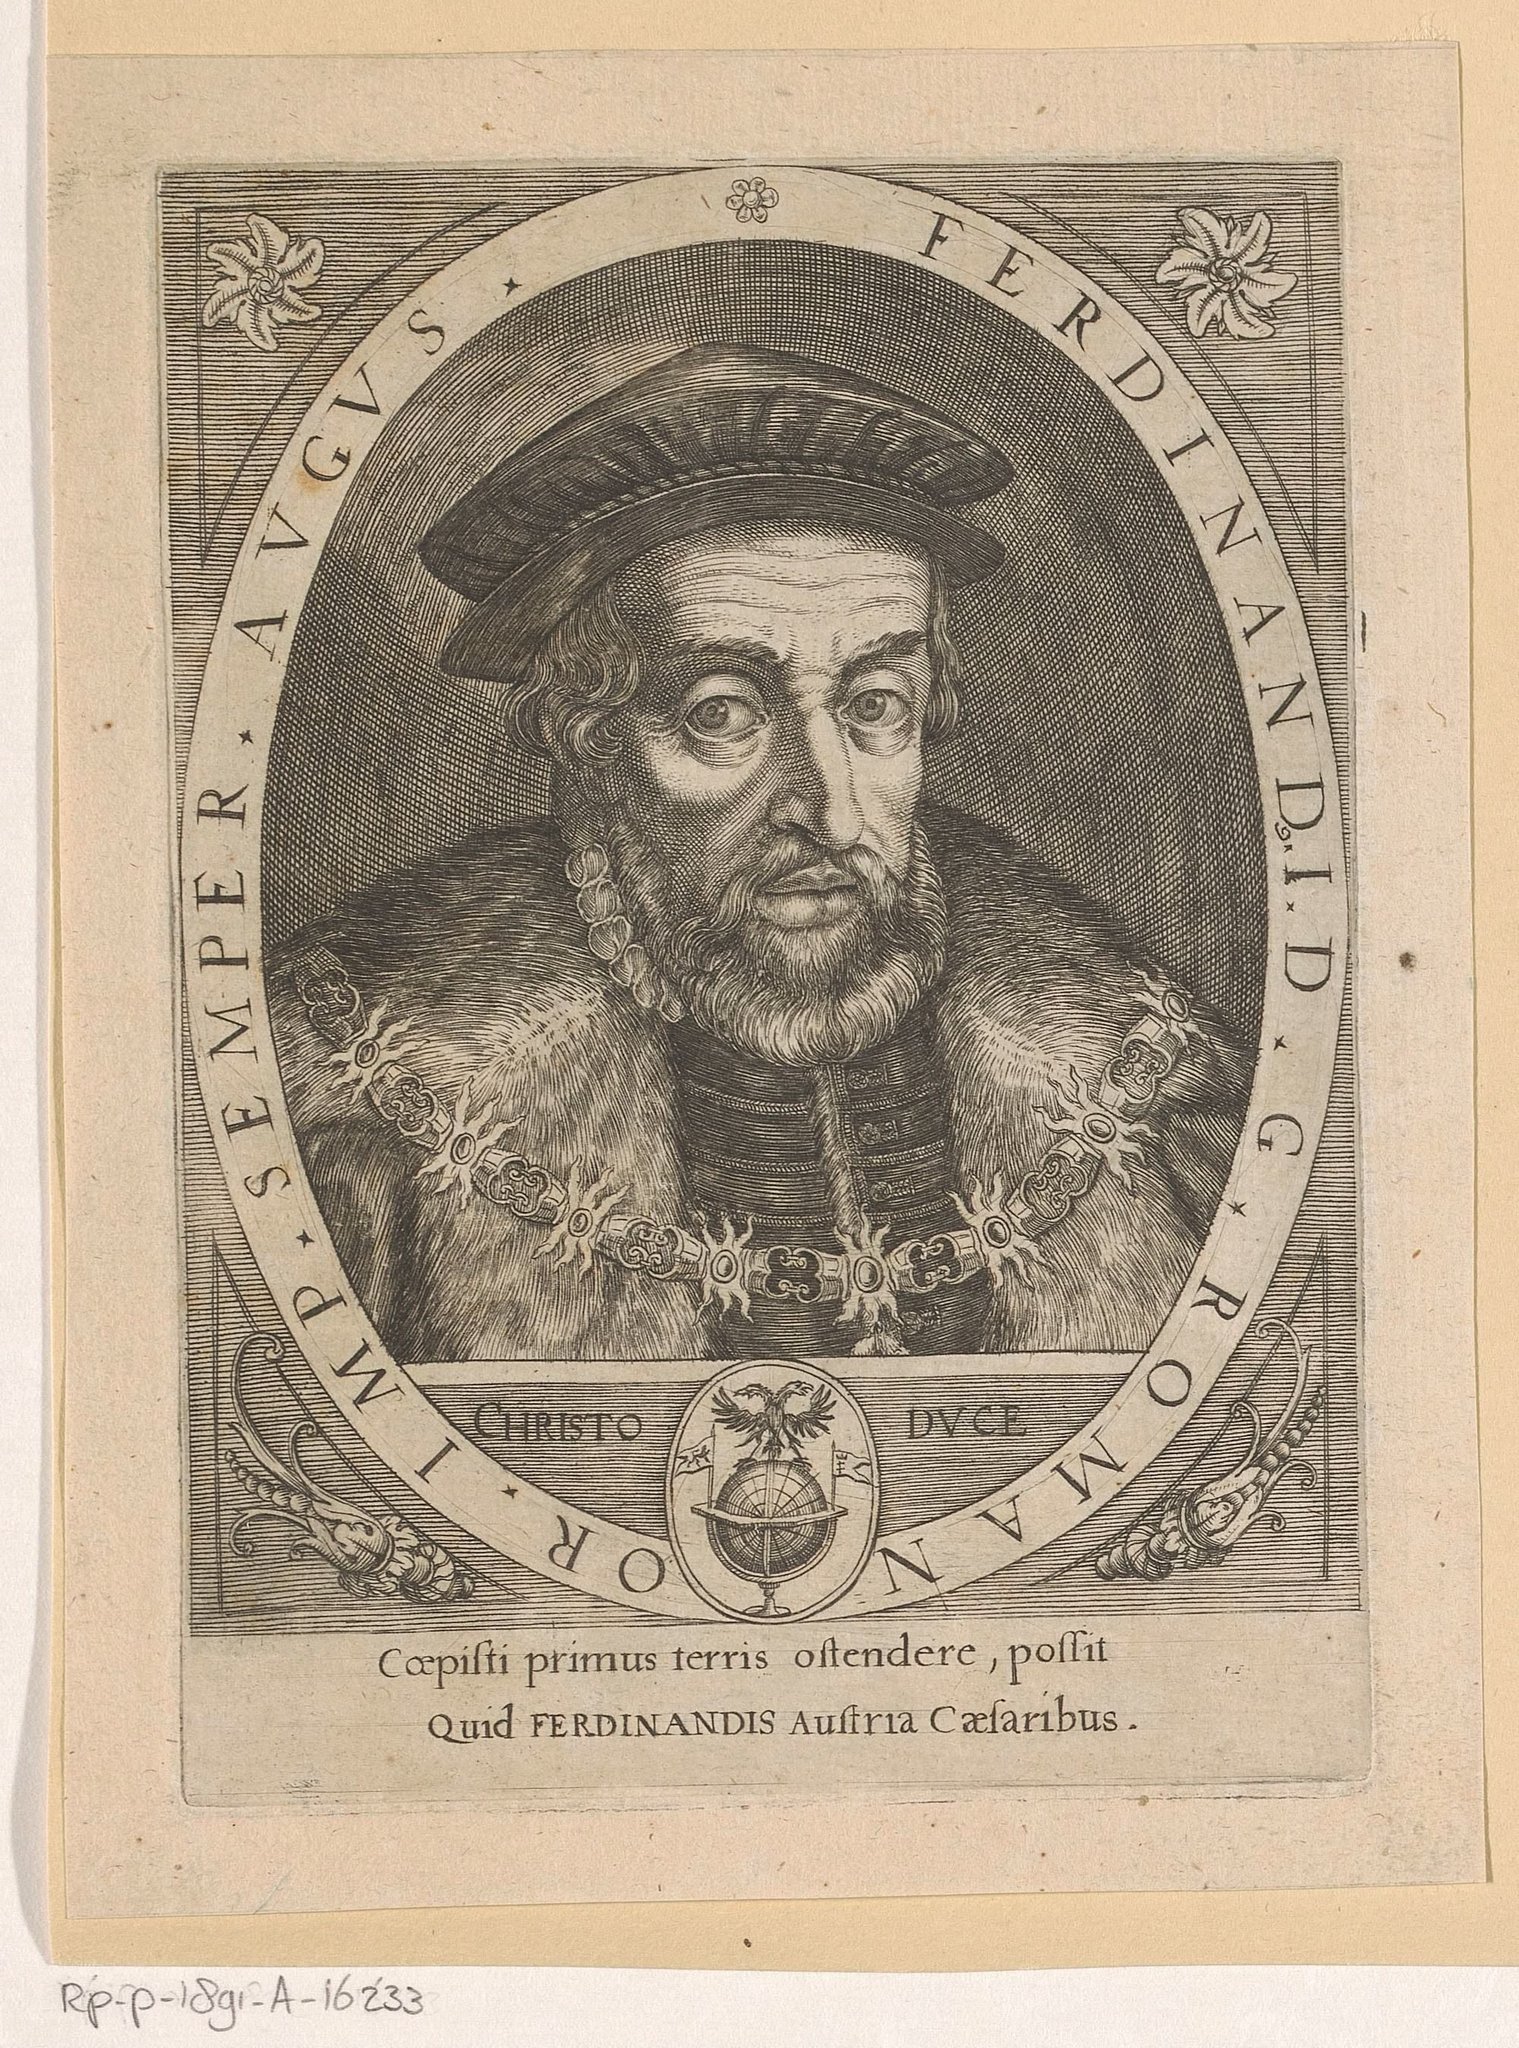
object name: print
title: Portret van keizer Ferdinand I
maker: johann caspar dooms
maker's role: print maker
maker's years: 1597-1685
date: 1650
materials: paper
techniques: engraving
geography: prague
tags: vienna, ferdinand i van habsburg (duits keizer), double-headed eagle, historical persons, ruler, sovereign, knighthood order of the golden fleece - insignia of a knighthood order, e.g.: badge, chain (with name of order), globe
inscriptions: collector's mark: Lugt 2228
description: Tweekoppige adelaar op een globe onder het portret. Met onderschrift in het Latijn.